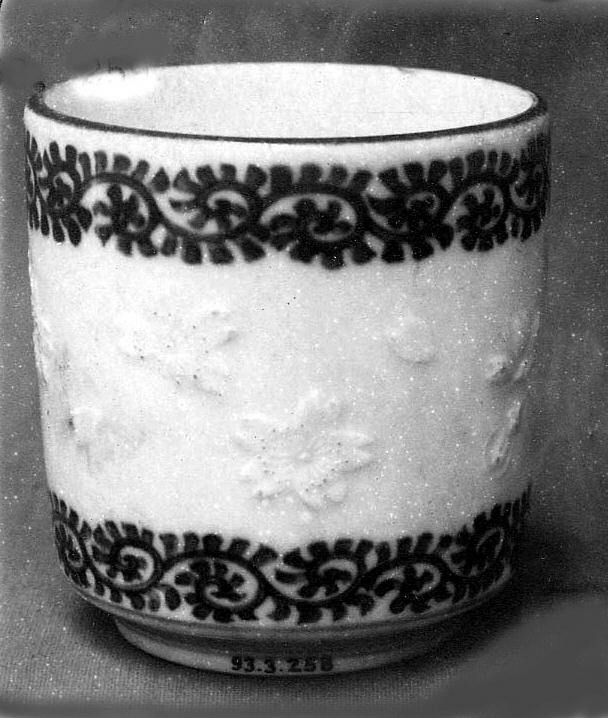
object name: cup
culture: japanese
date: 1780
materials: glaze, porcelain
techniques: relief